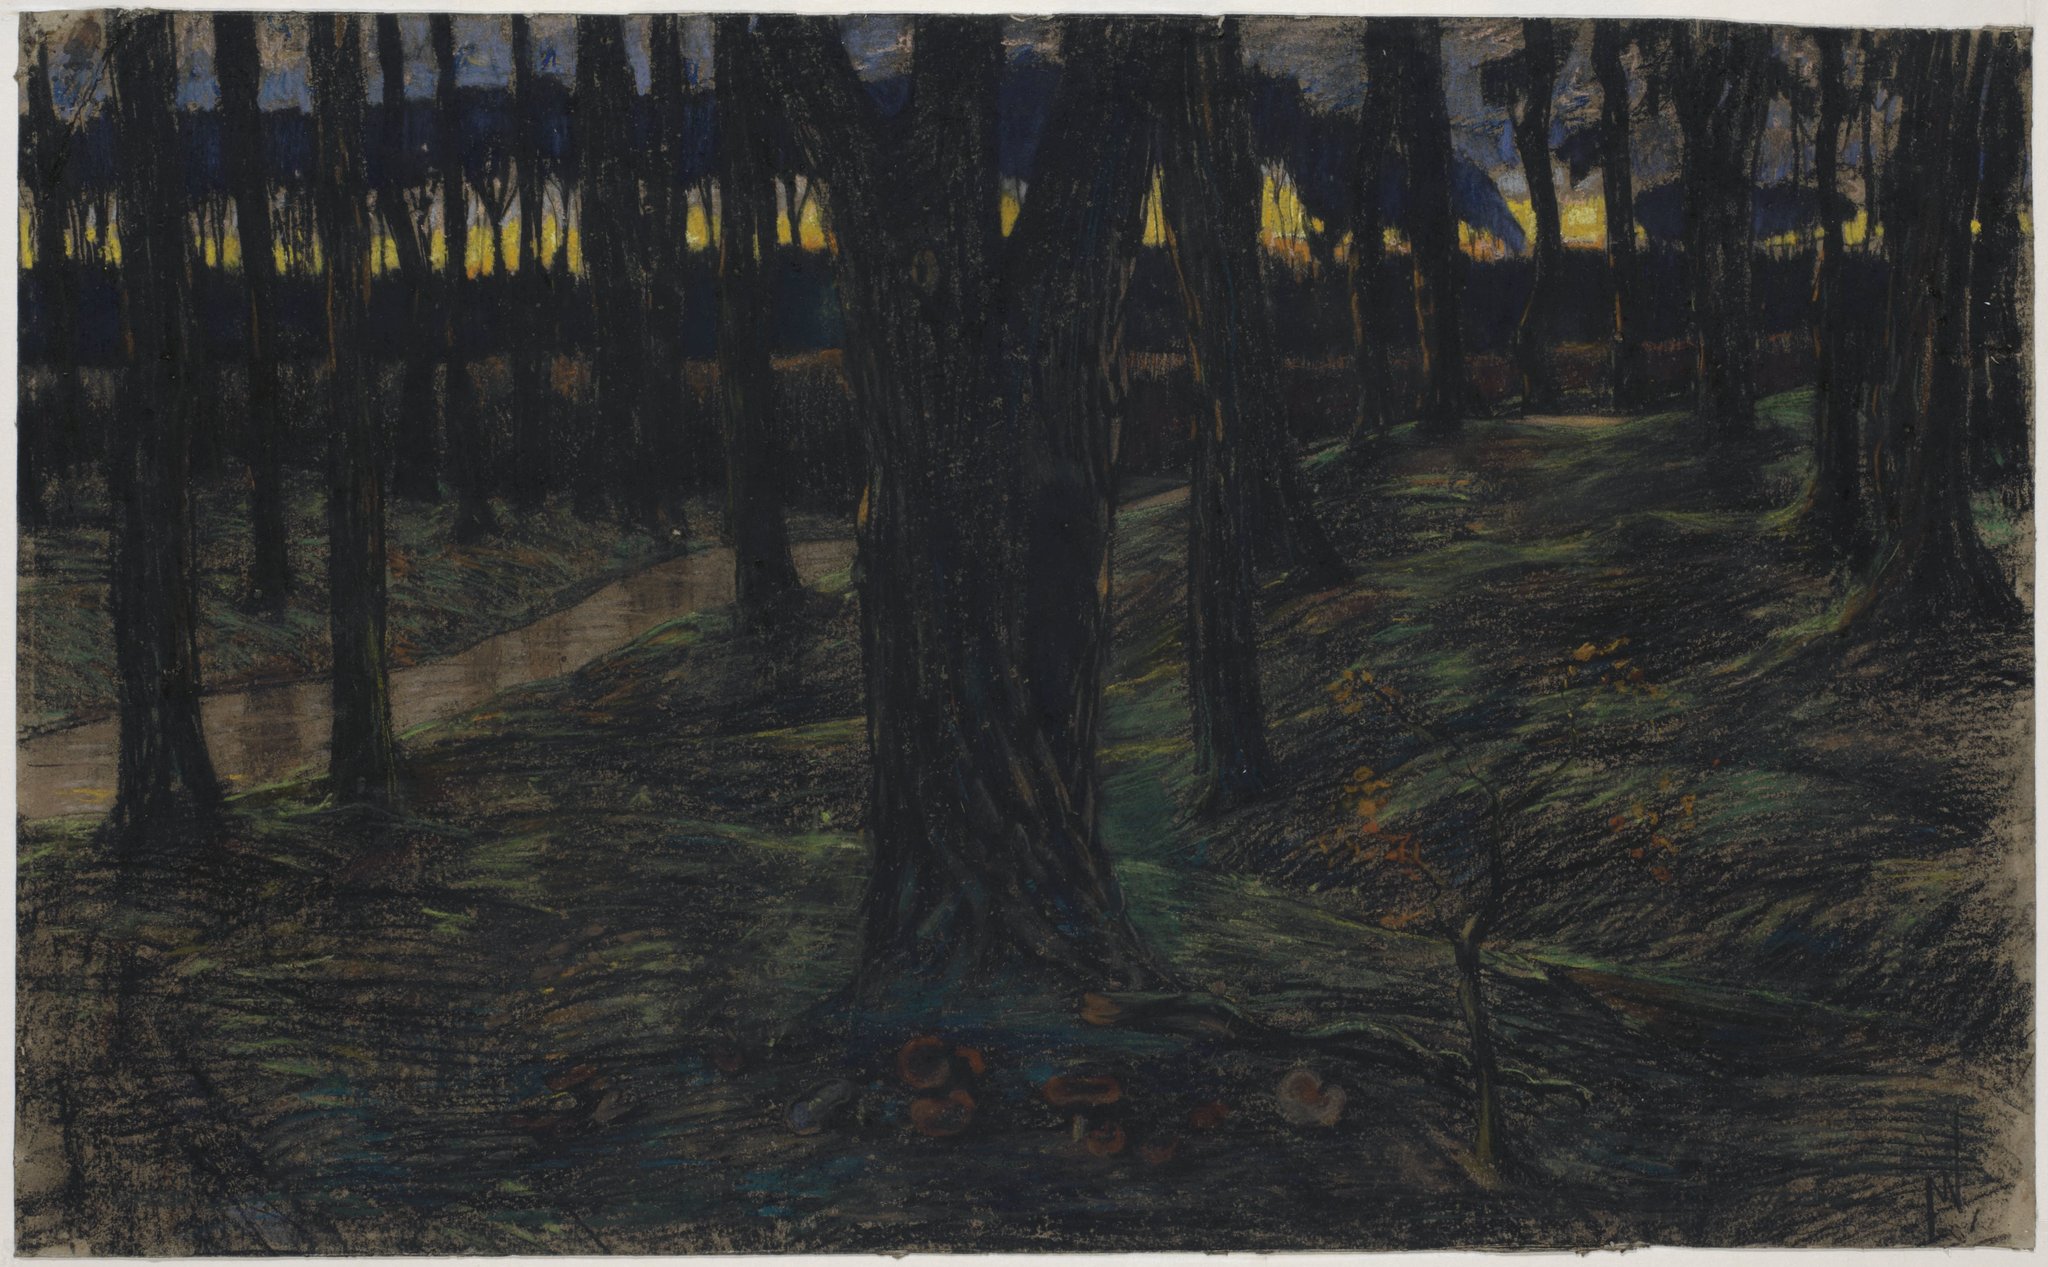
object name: drawing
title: Bosgezicht bij zonsondergang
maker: maurits van der valk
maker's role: draughtsman, print maker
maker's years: 1857-1935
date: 1867-1935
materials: chalk, paper, pastel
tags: forest, wood